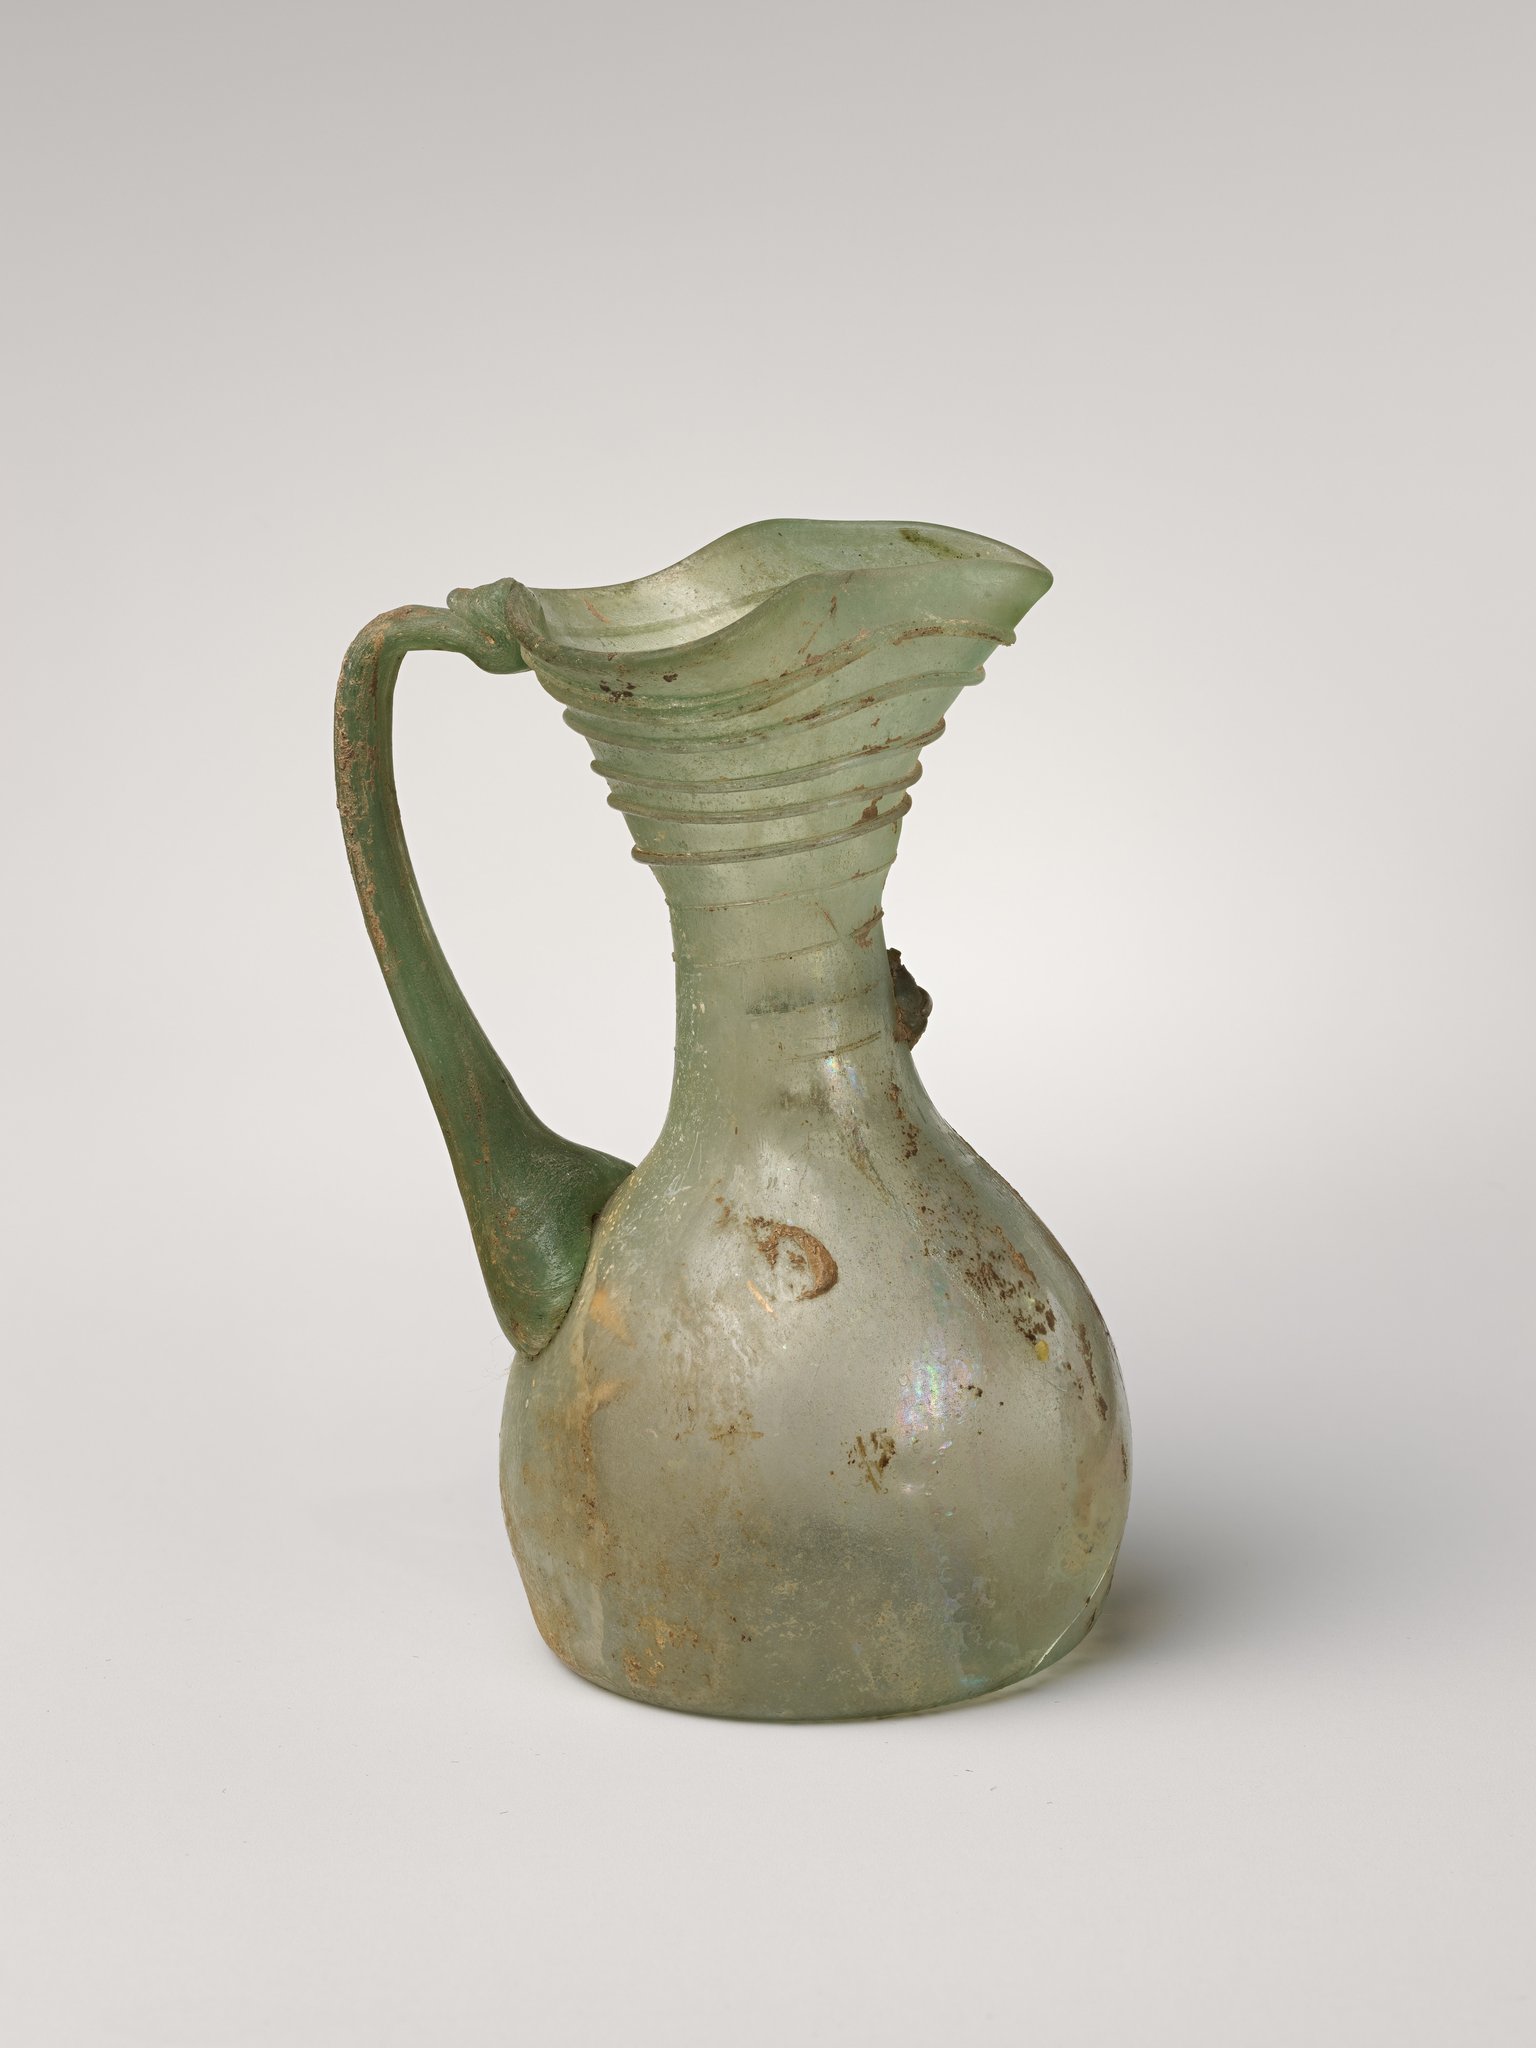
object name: oinochoe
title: Glass jug with trefoil rim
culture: roman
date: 301-500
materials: glass